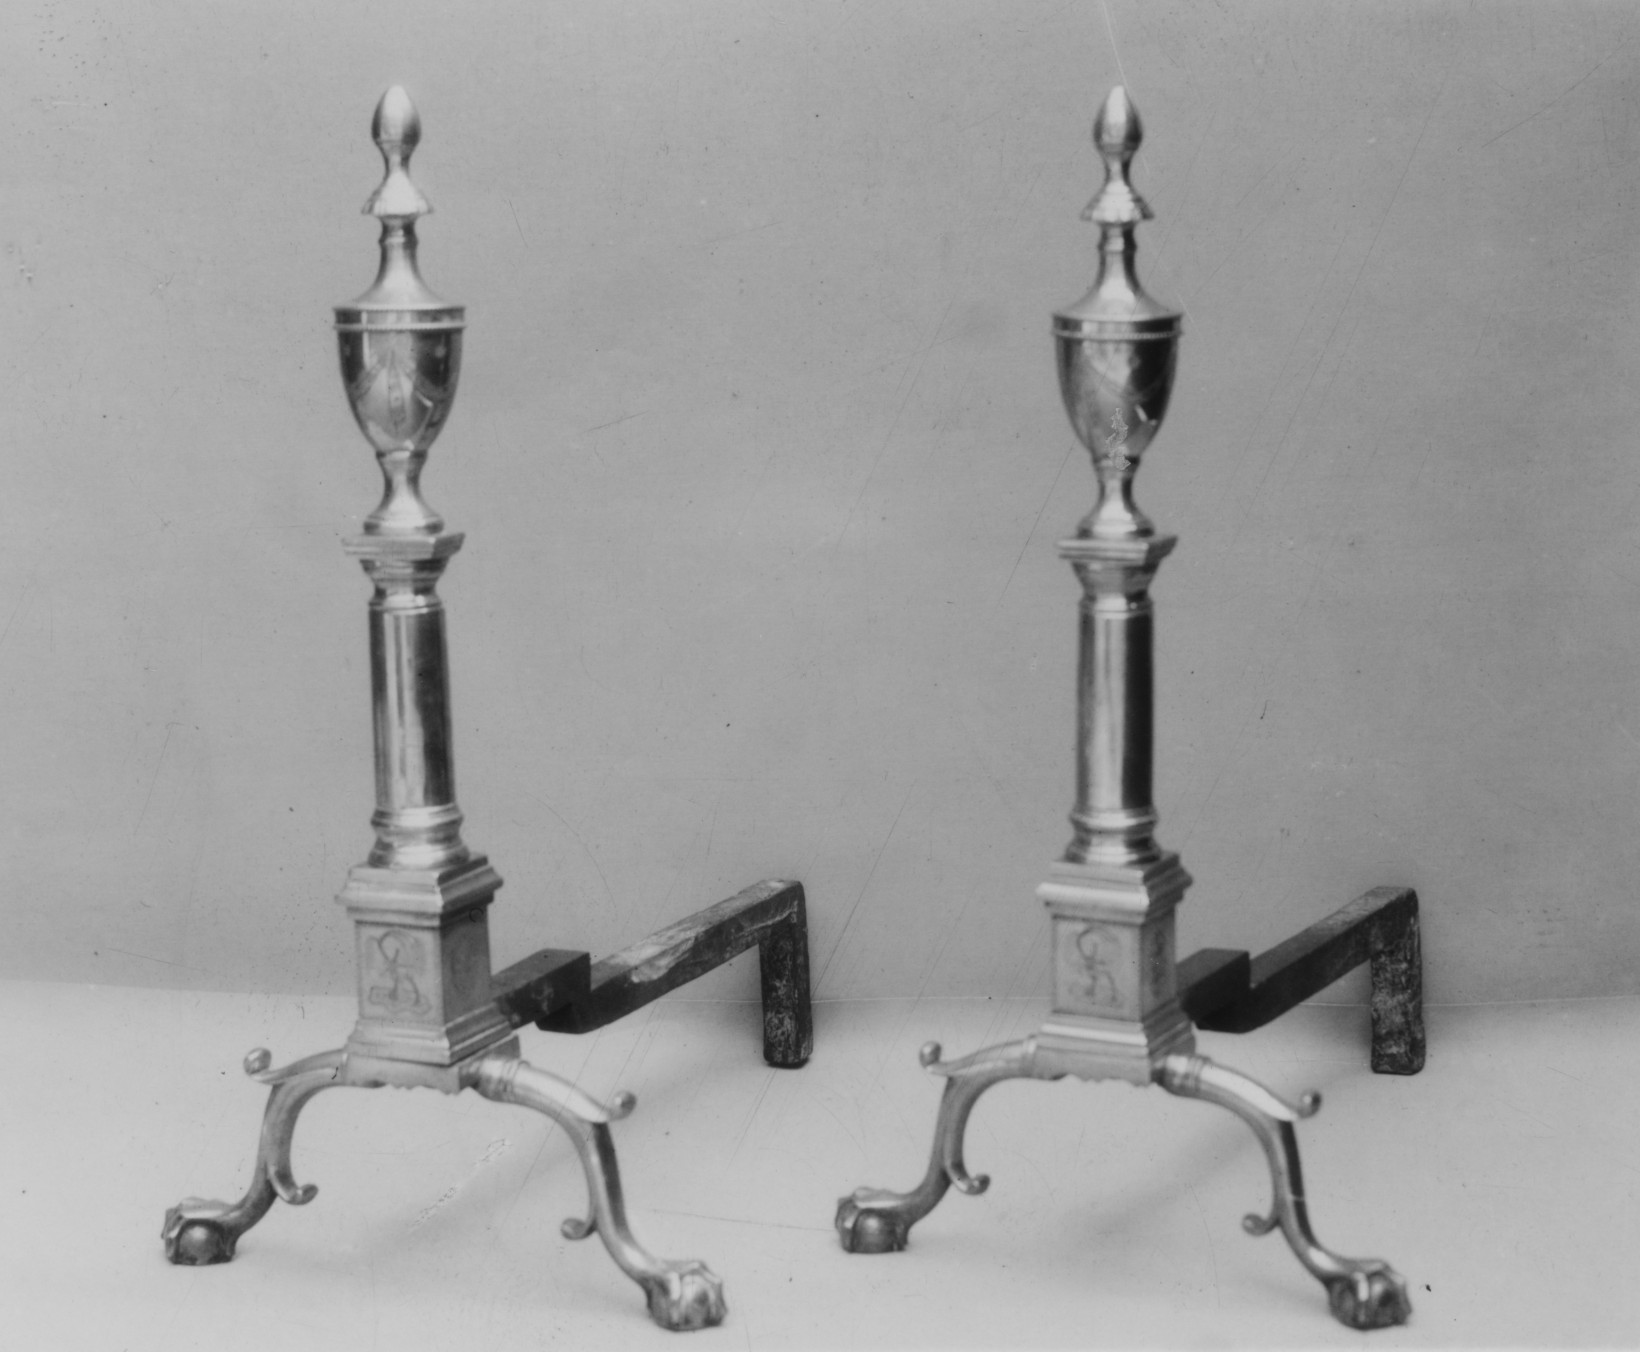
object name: andiron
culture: american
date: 1795-1810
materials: brass, iron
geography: united states